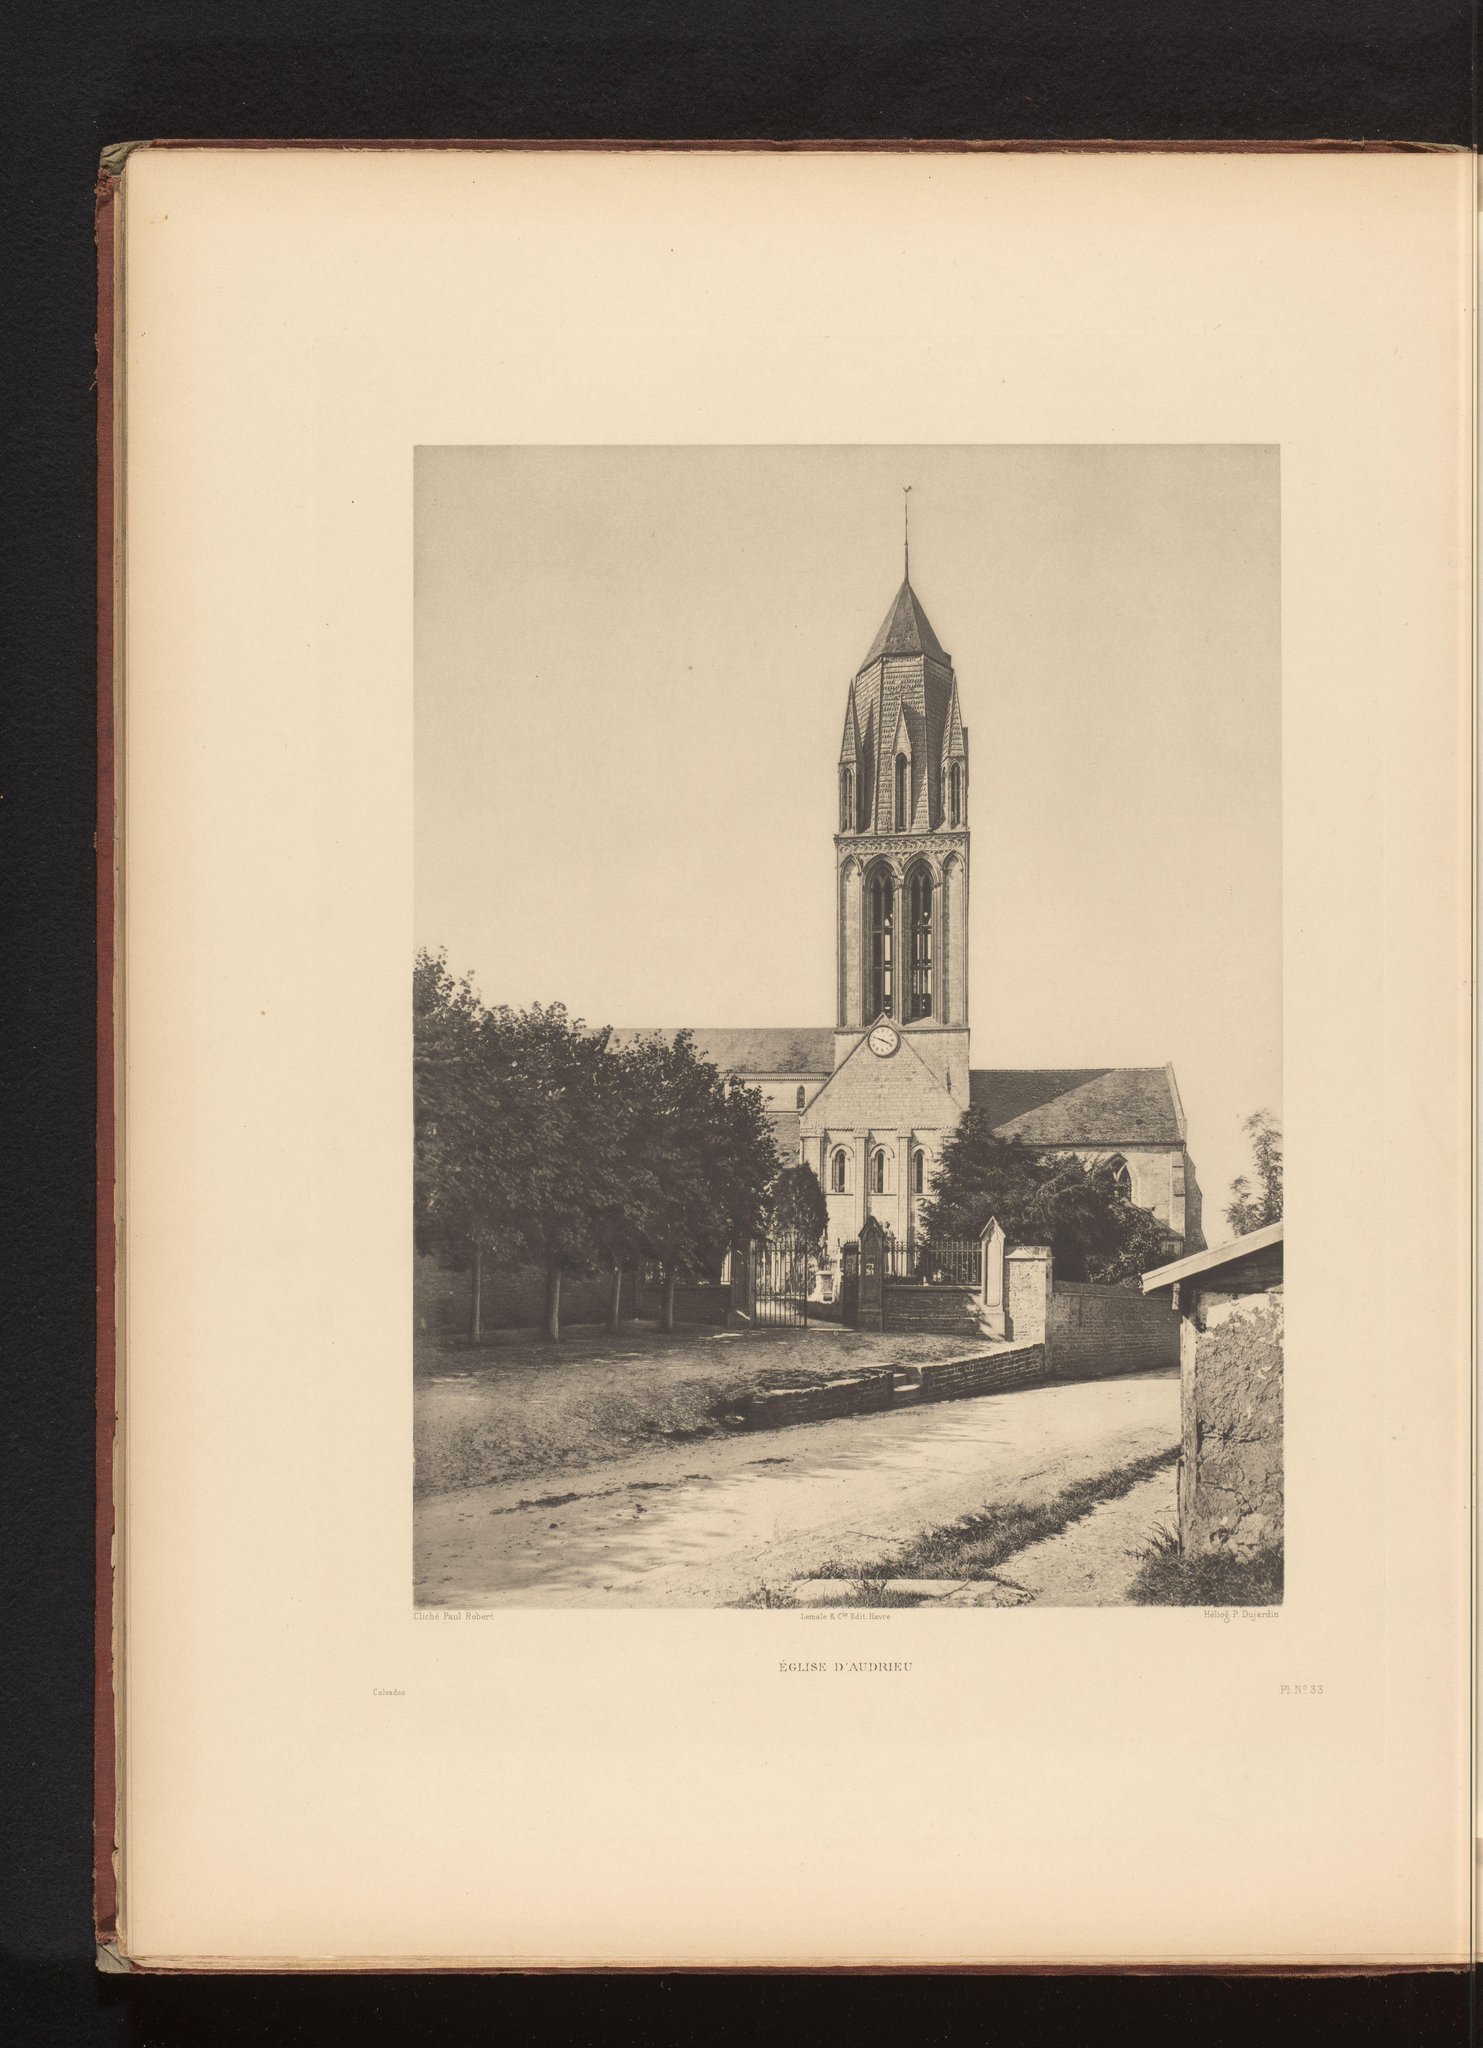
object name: page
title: Gezicht op de Église Notre-Dame in Audrieu, Normandië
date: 1890-1895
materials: paper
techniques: photoaquatint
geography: le havre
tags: church (exterior)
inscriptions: number: ‘Pl. No. 33’, inscription: ‘Calvados.’